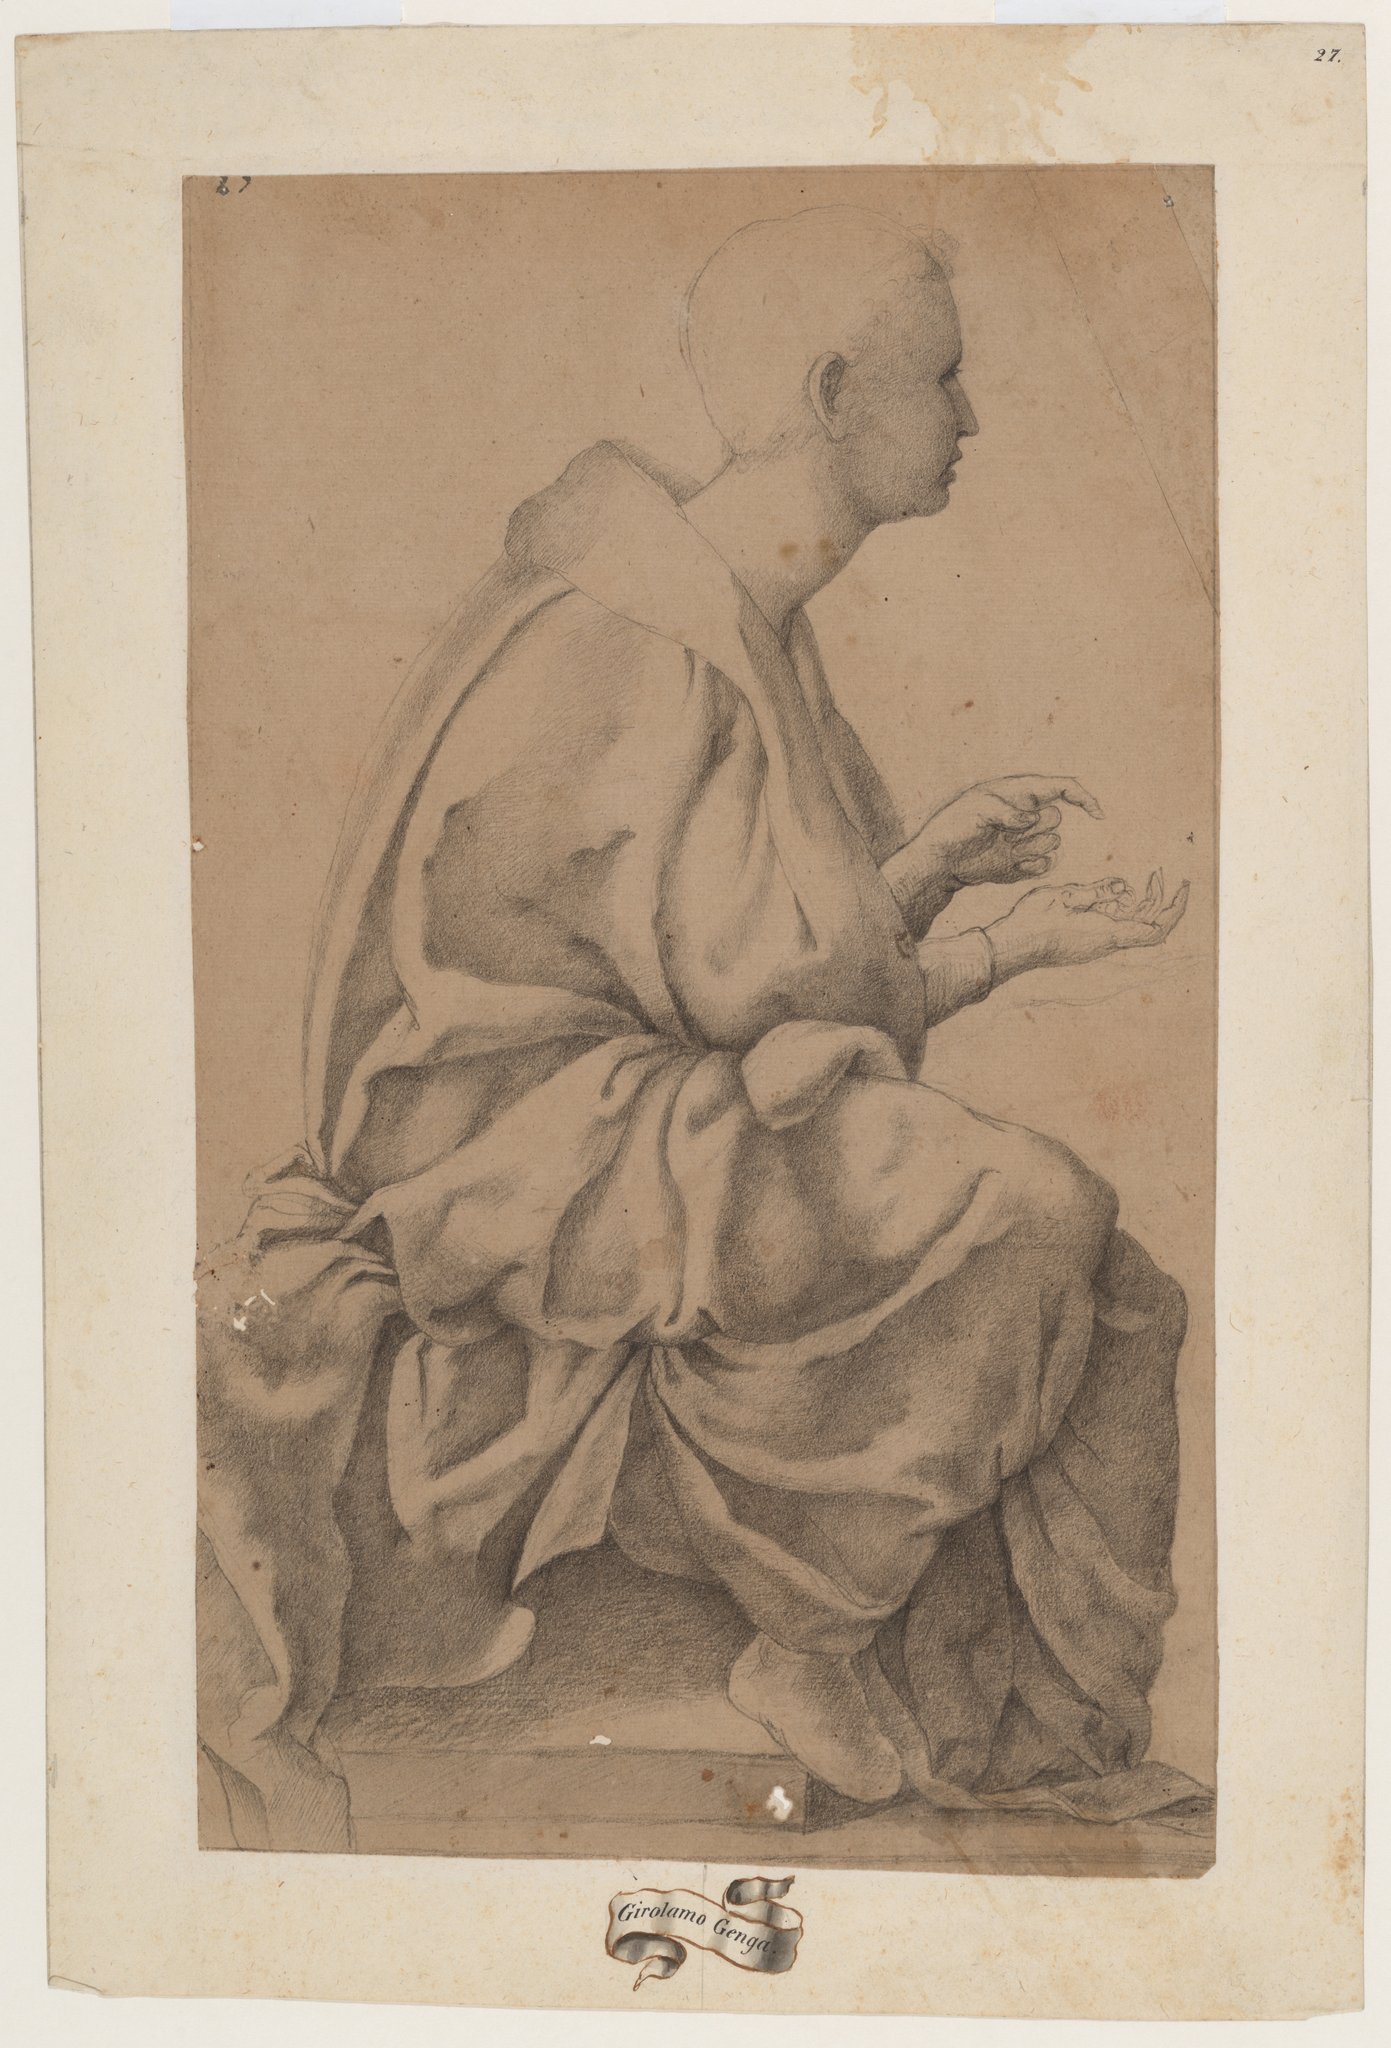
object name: drawing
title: Study for a seated draped figure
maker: girolamo genga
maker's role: artist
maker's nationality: italian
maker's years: 1467-1551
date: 1516-1518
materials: chalk